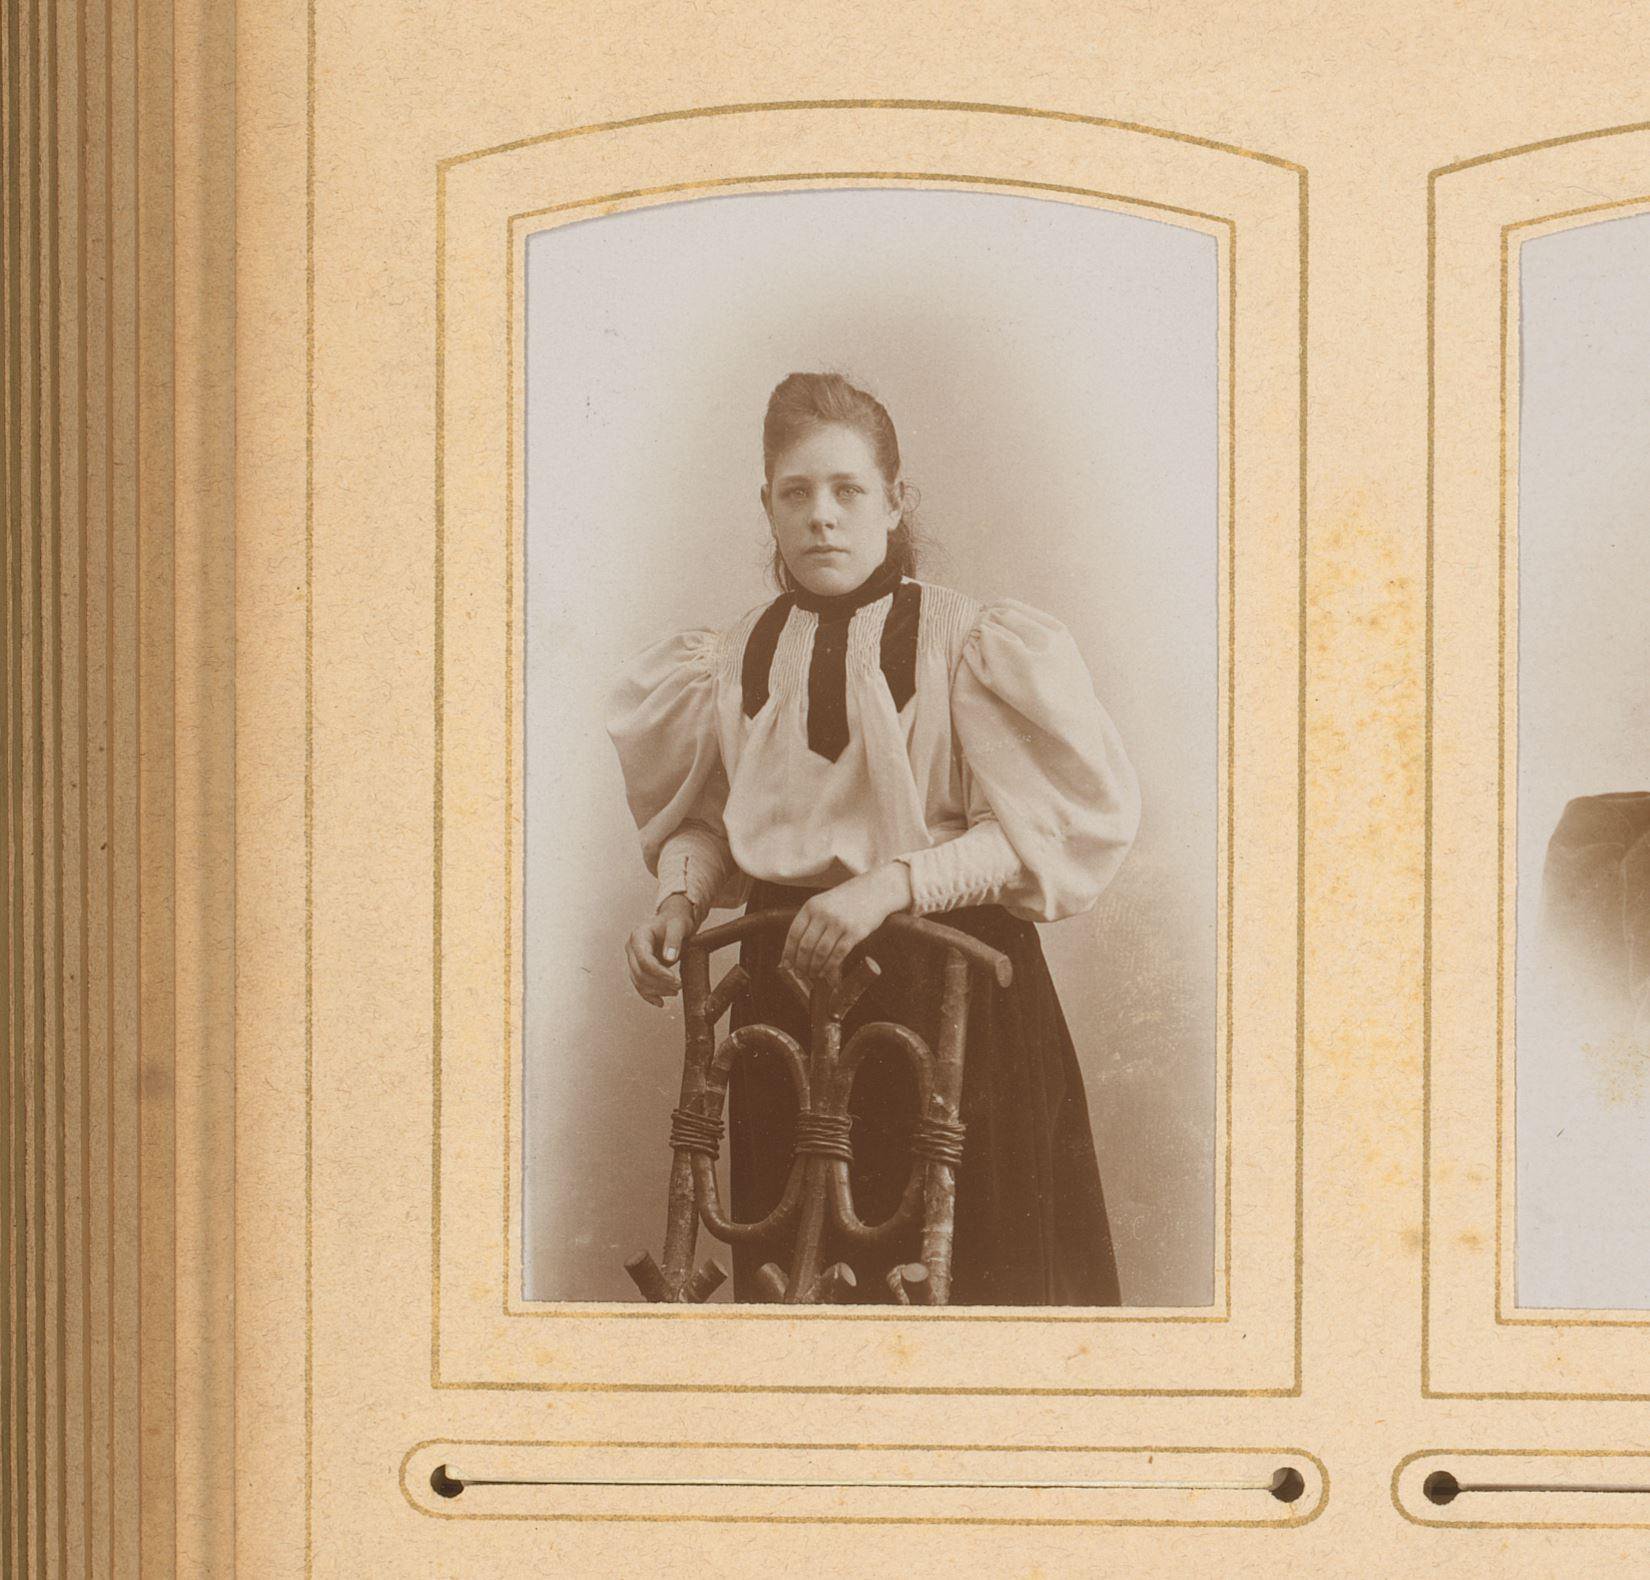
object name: carte de visite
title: Portret van een jonge vrouw, staand bij een stoel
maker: leon a. van weijderveldt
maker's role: fotograaf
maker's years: 1814-1888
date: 1880-1888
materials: cardboard, photographic support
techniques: collodion silver print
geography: amsterdam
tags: adolescent, young woman, maiden, historical persons - bb - woman, standing figure - aa - female human figure, chair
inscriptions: inscription: ‘Léon A. van Weijderveldt/ AMSTERDAM./ n.z.Voorburgwal 232/ b/d Paleisstraat.’